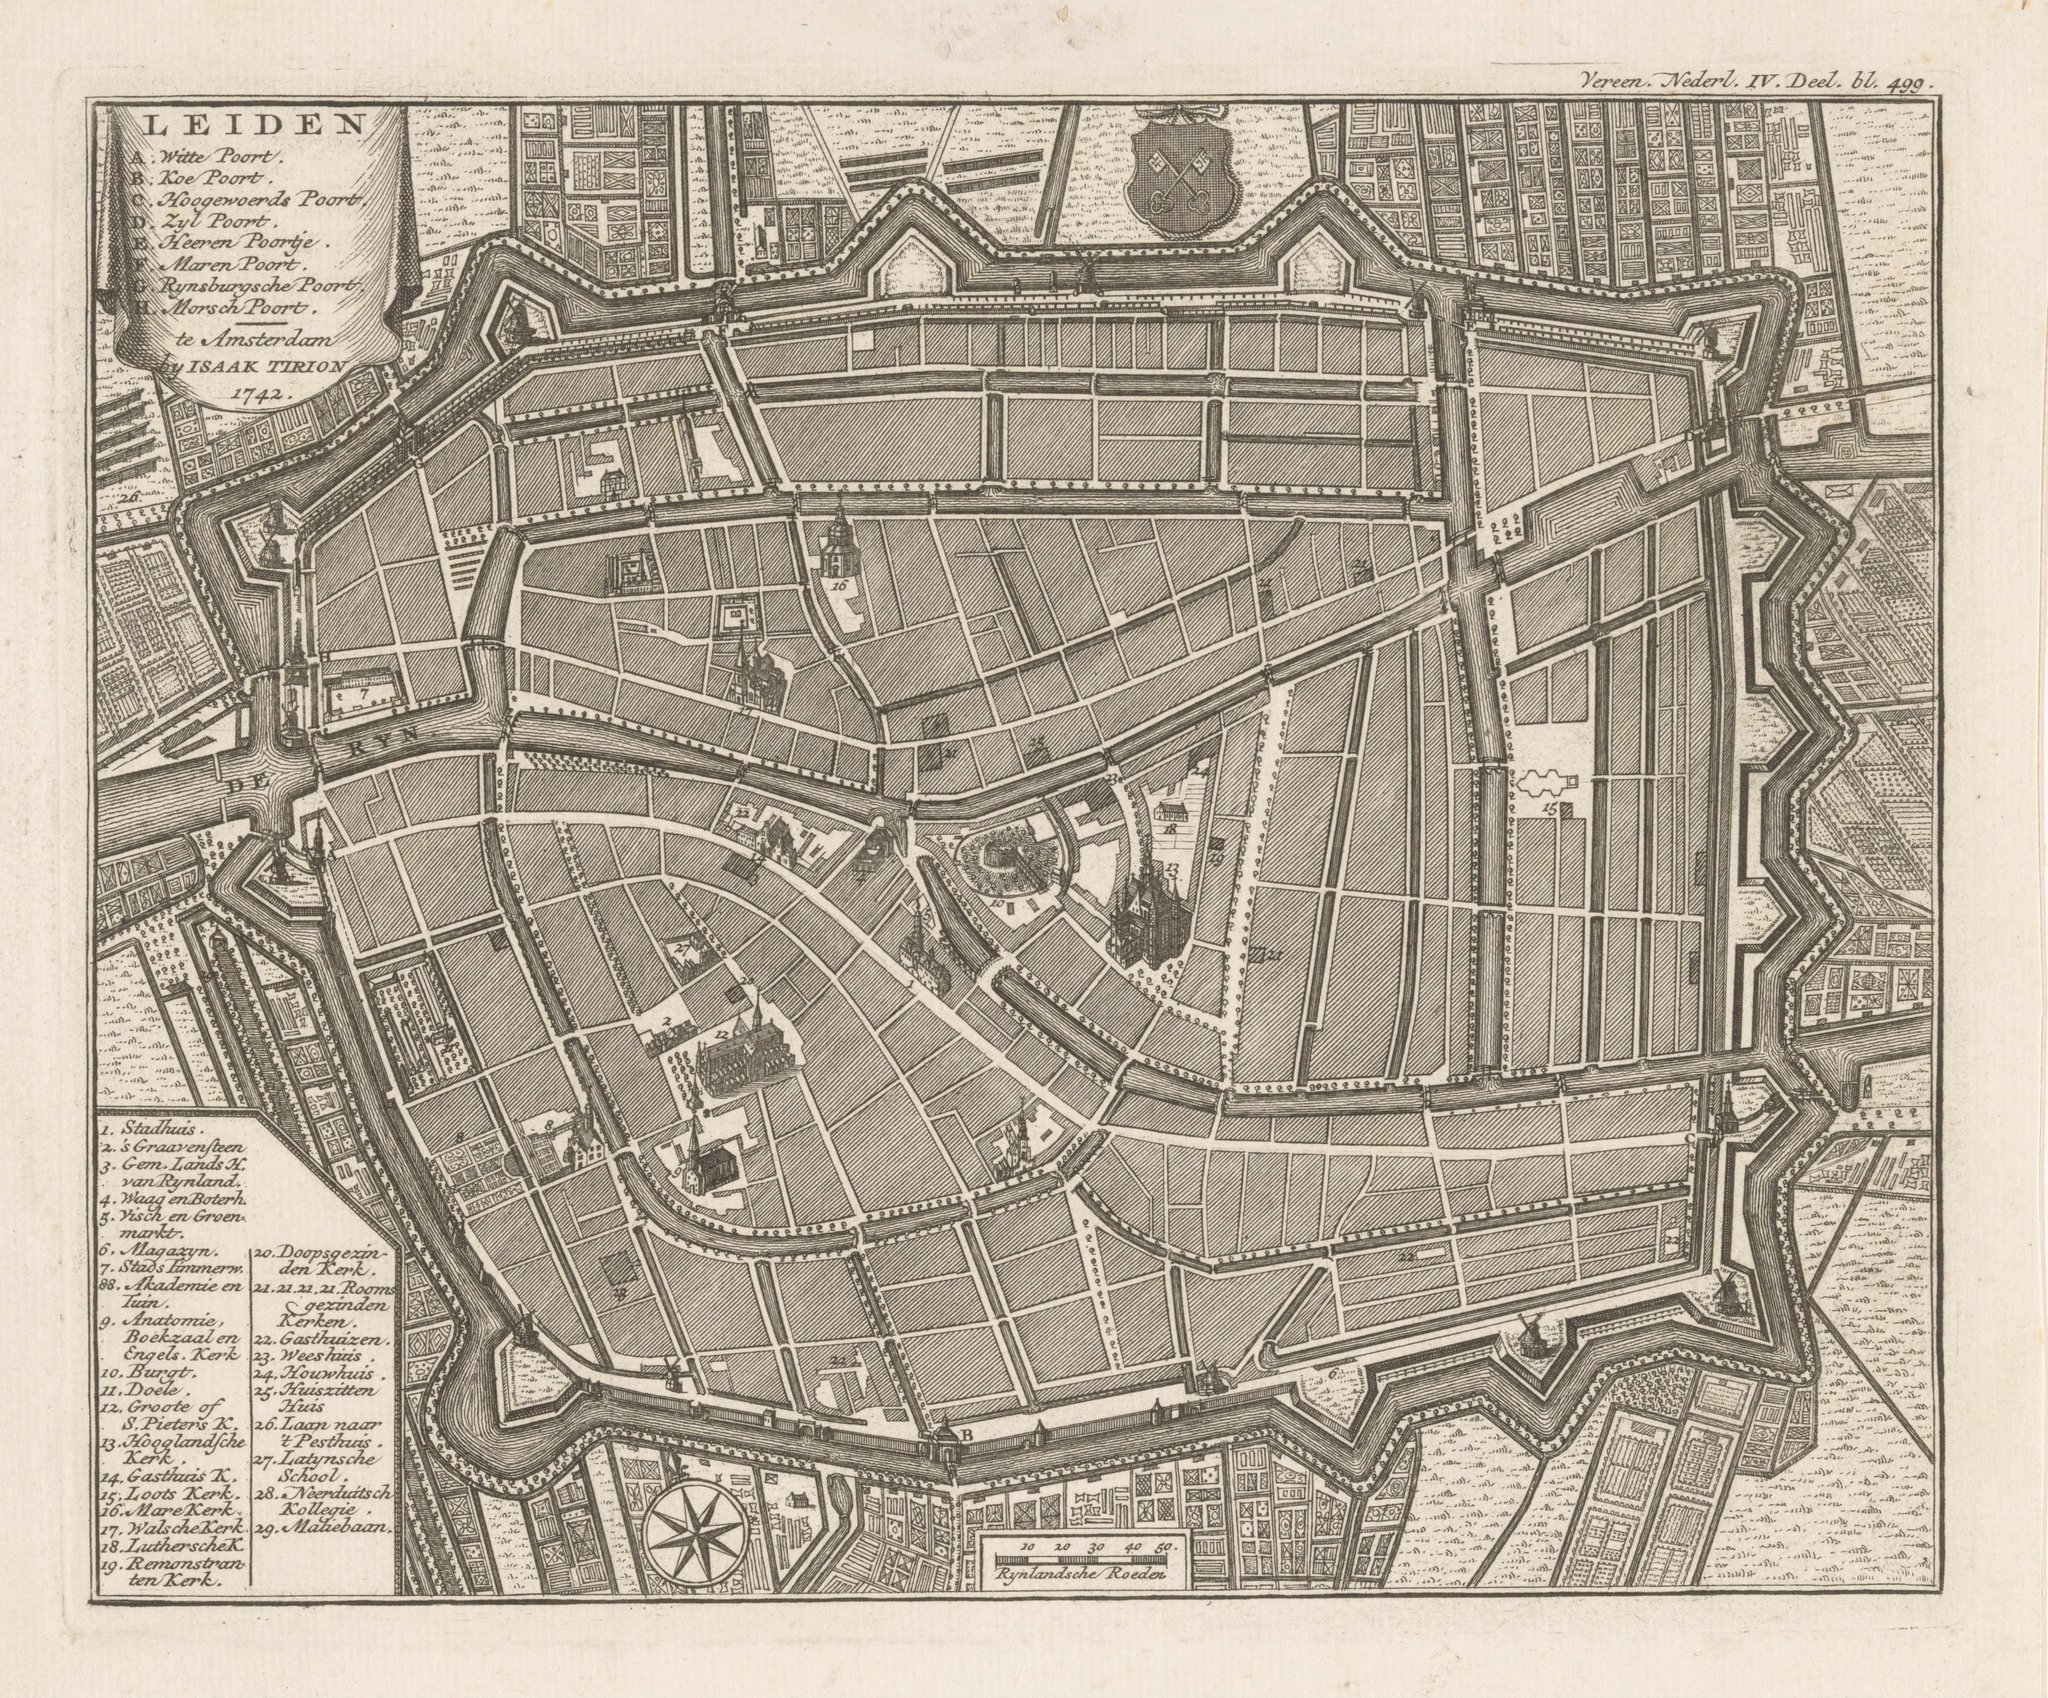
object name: book illustration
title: Leiden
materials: paper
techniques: engraving, etching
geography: amsterdam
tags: maps of cities, leiden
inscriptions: collector's mark: Lugt 2228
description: Plattegrond in vogelvluchtperspectief. Linksboven de titel en een legenda A-H. Linksonder een legenda 1-29. Onder in het midden een schaalstok: 50 Rynlandsche roeden. Rechtsboven gemerkt: Vereen. Nederl. IV. Deel. Bl. 499.